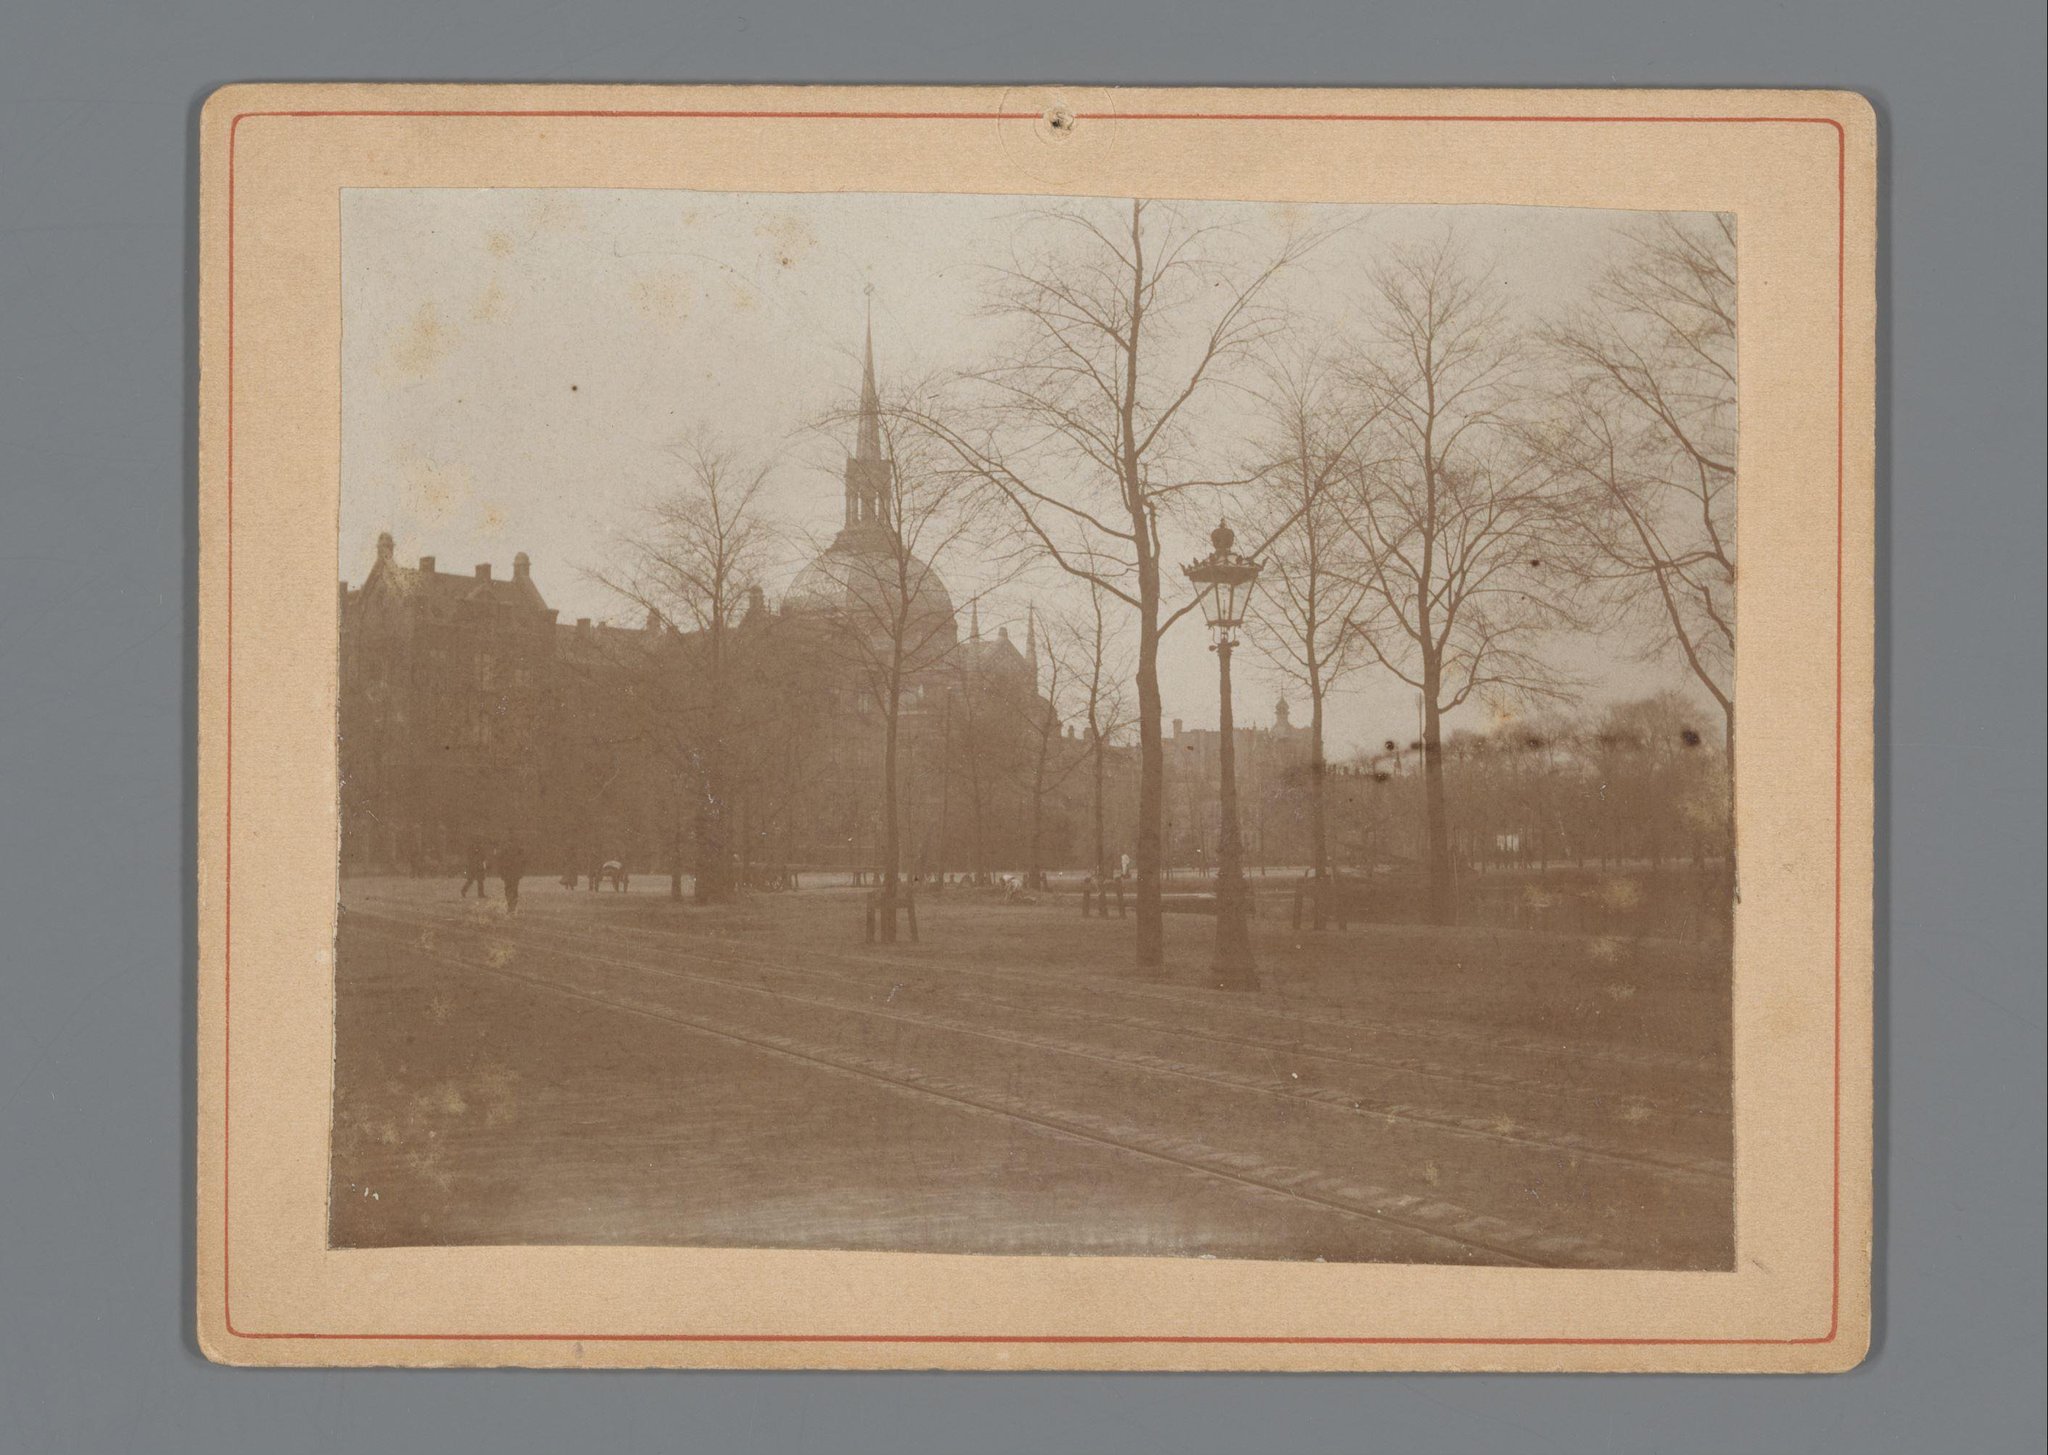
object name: photograph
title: Gezicht op het Leidsebosje en de Koepelkerk te Amsterdam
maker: Anonymous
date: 1890-1910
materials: cardboard, photographic support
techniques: collodion silver print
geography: amsterdam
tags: park, church (exterior)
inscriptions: annotation: ‘Leidse Bosje’